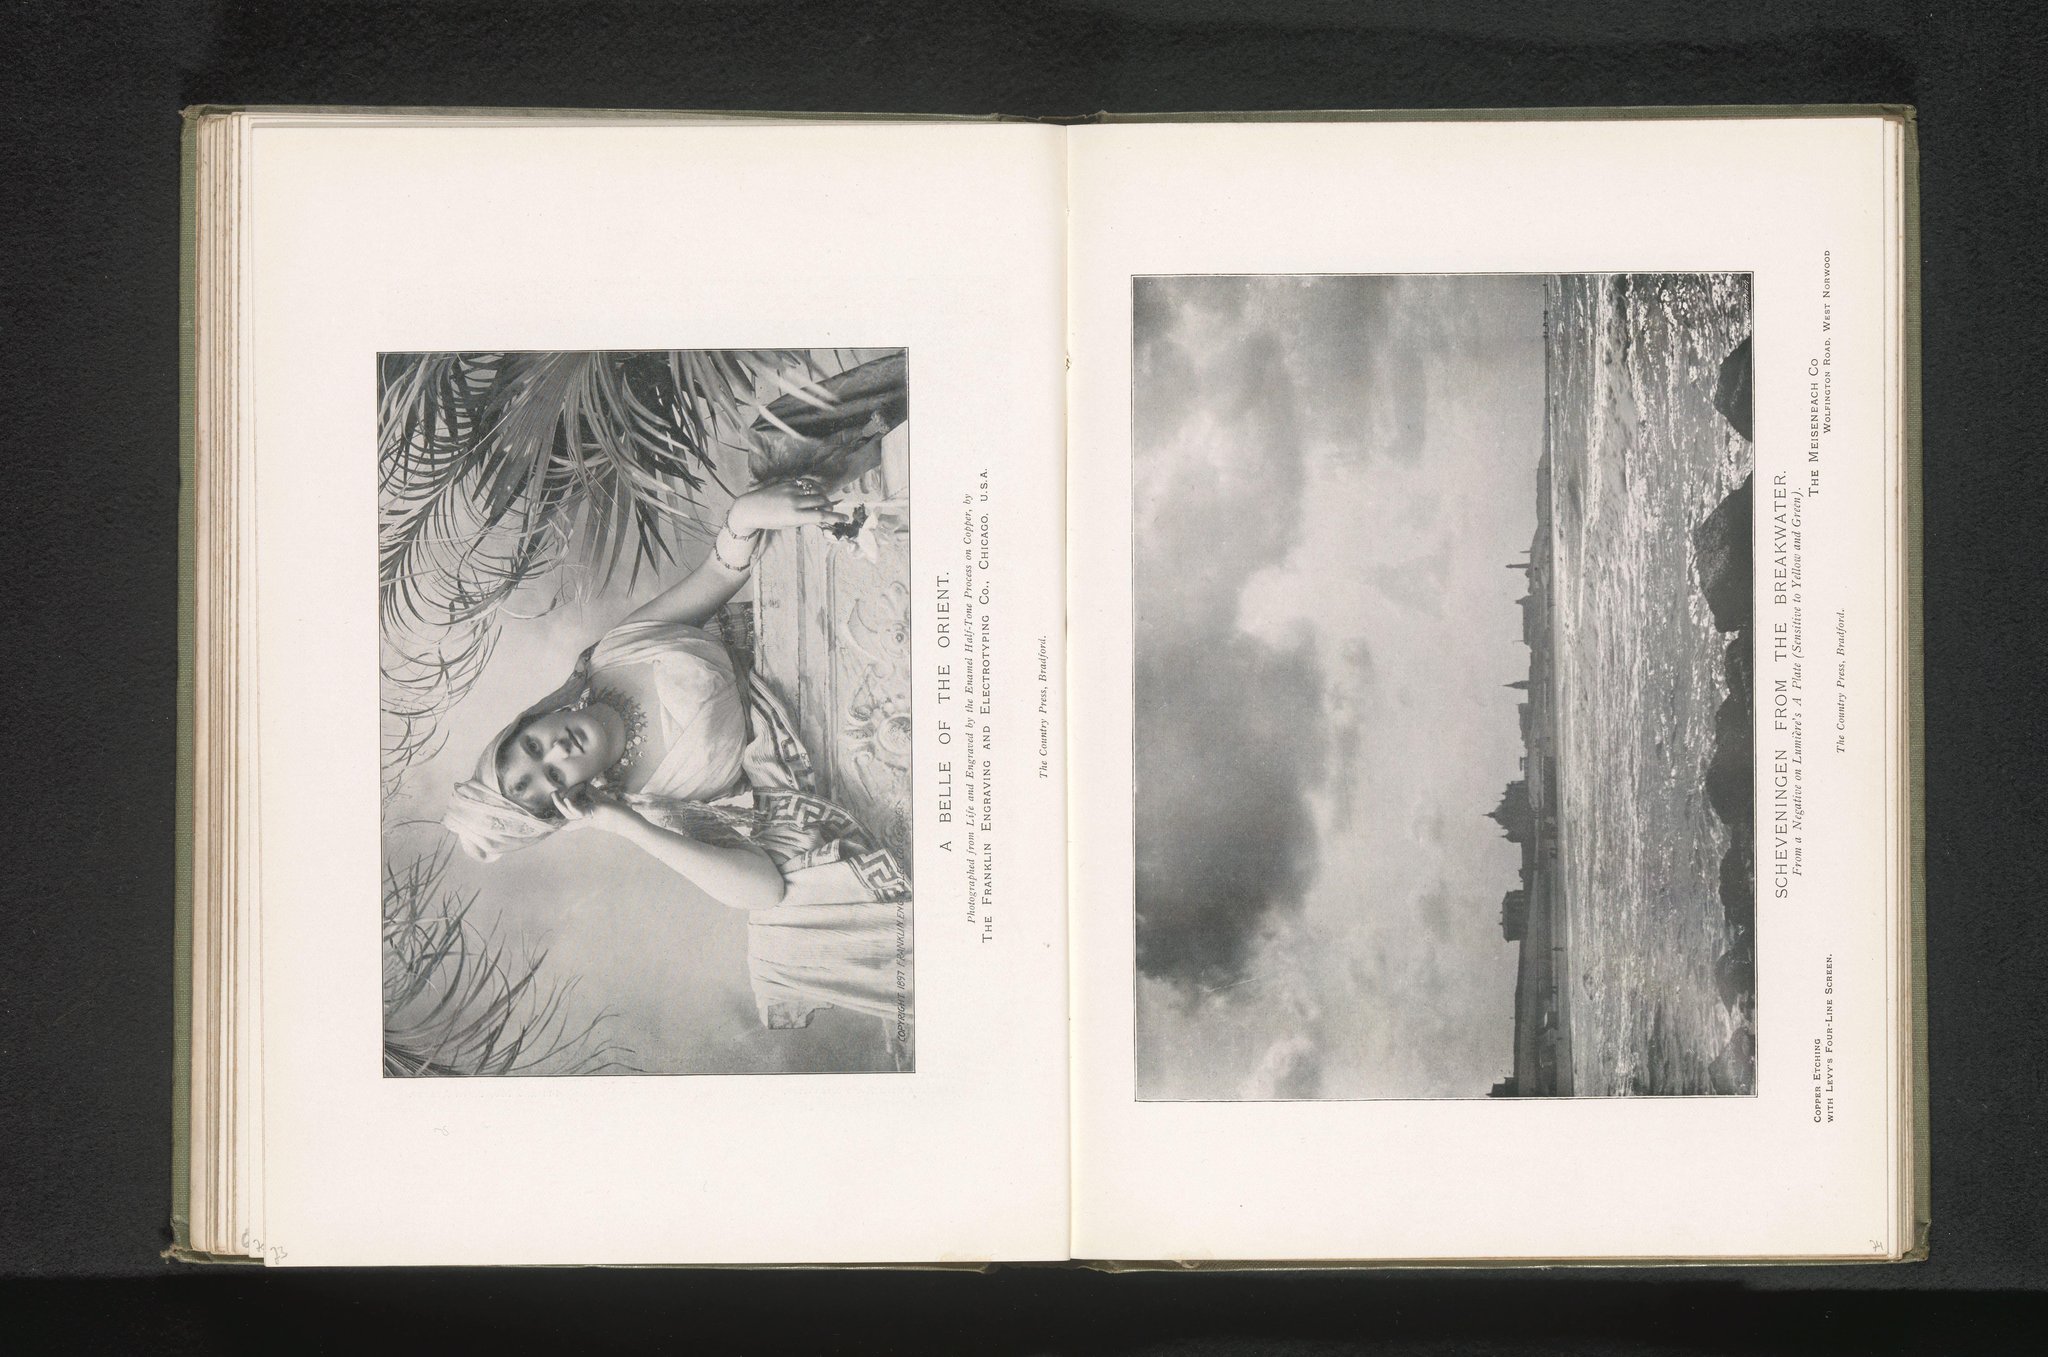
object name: page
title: A belle of the Orient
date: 1893-1898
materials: paper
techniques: autotype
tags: historical persons - bb - woman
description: Prent op tweede ongenummerde pagina na pagina 92.